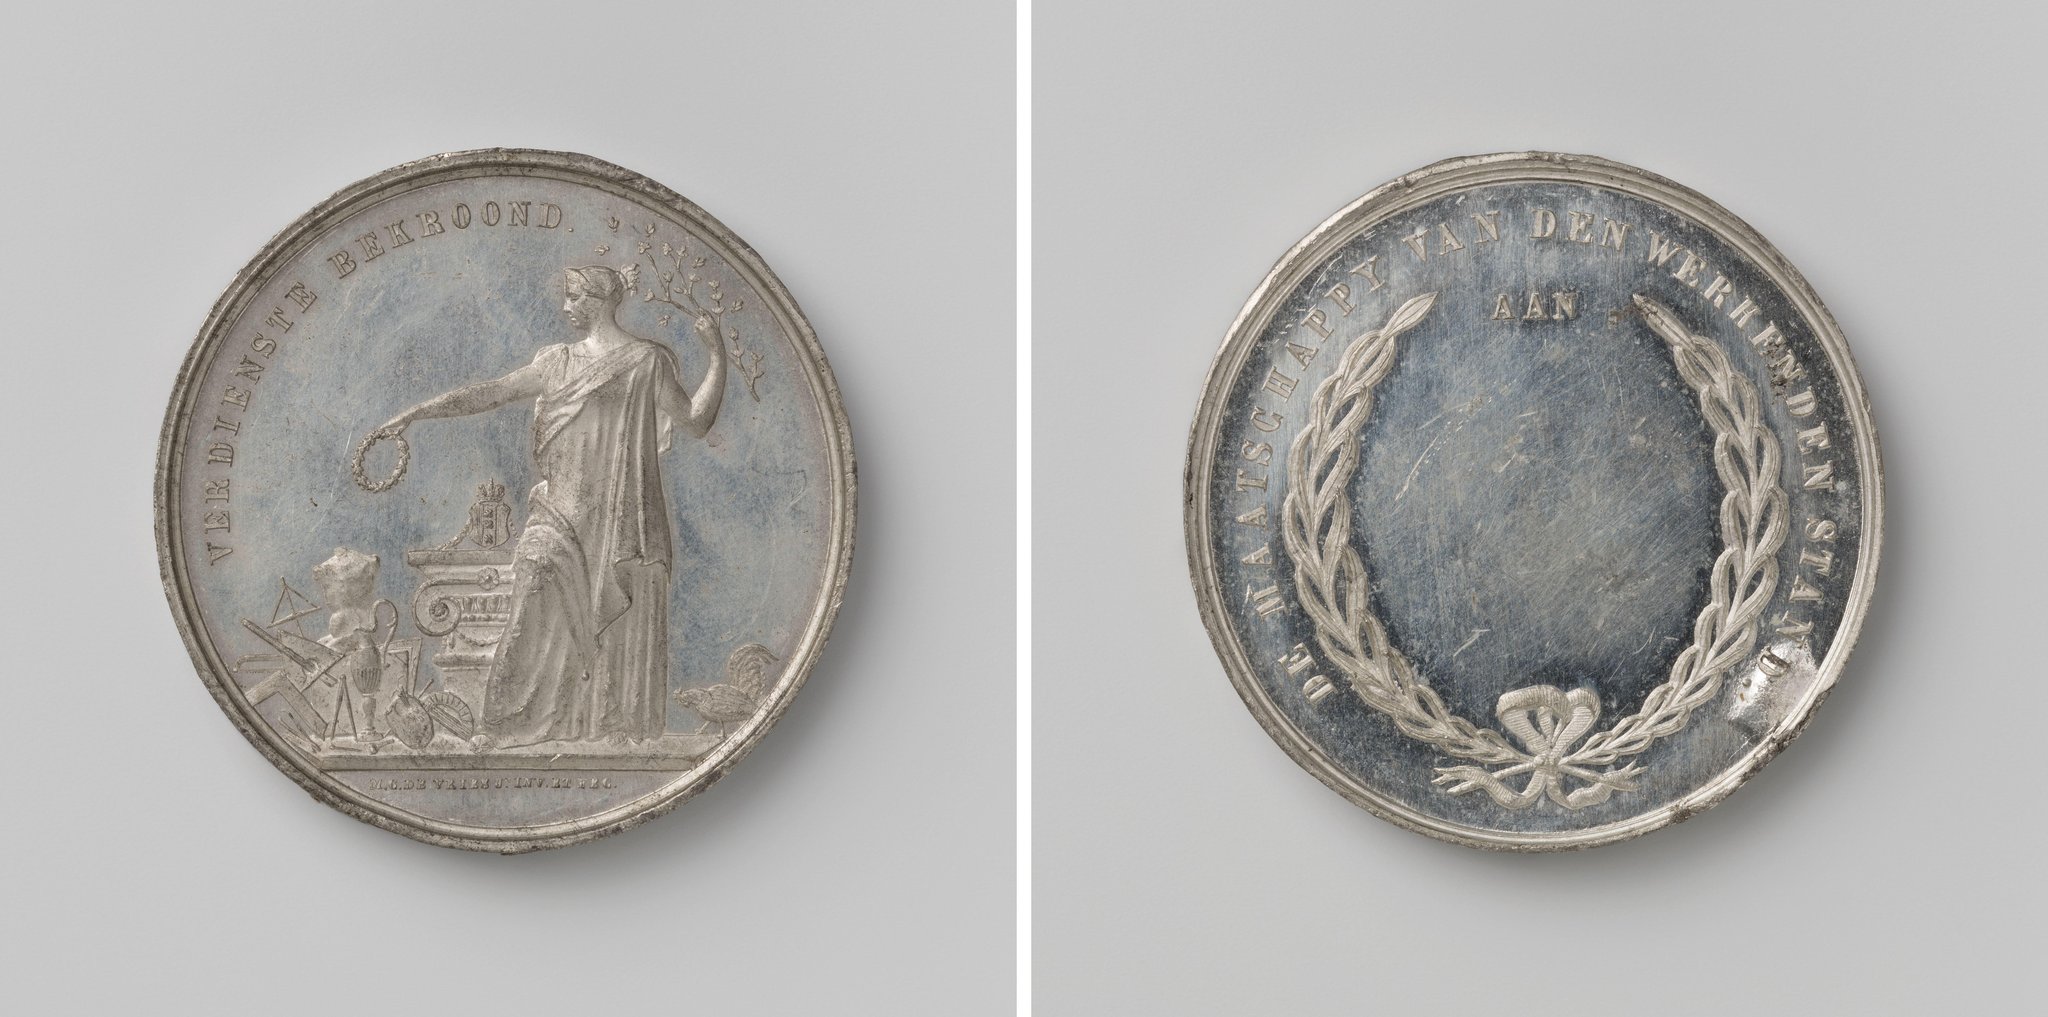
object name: medal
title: Maatschappij tot Verbetering van den Werkenden Stand te Amsterdam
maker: moses cohen de vries junior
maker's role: diamantslijper, graveur, medailleur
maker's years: 1807-1883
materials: tin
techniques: striking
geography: amsterdam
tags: amsterdam